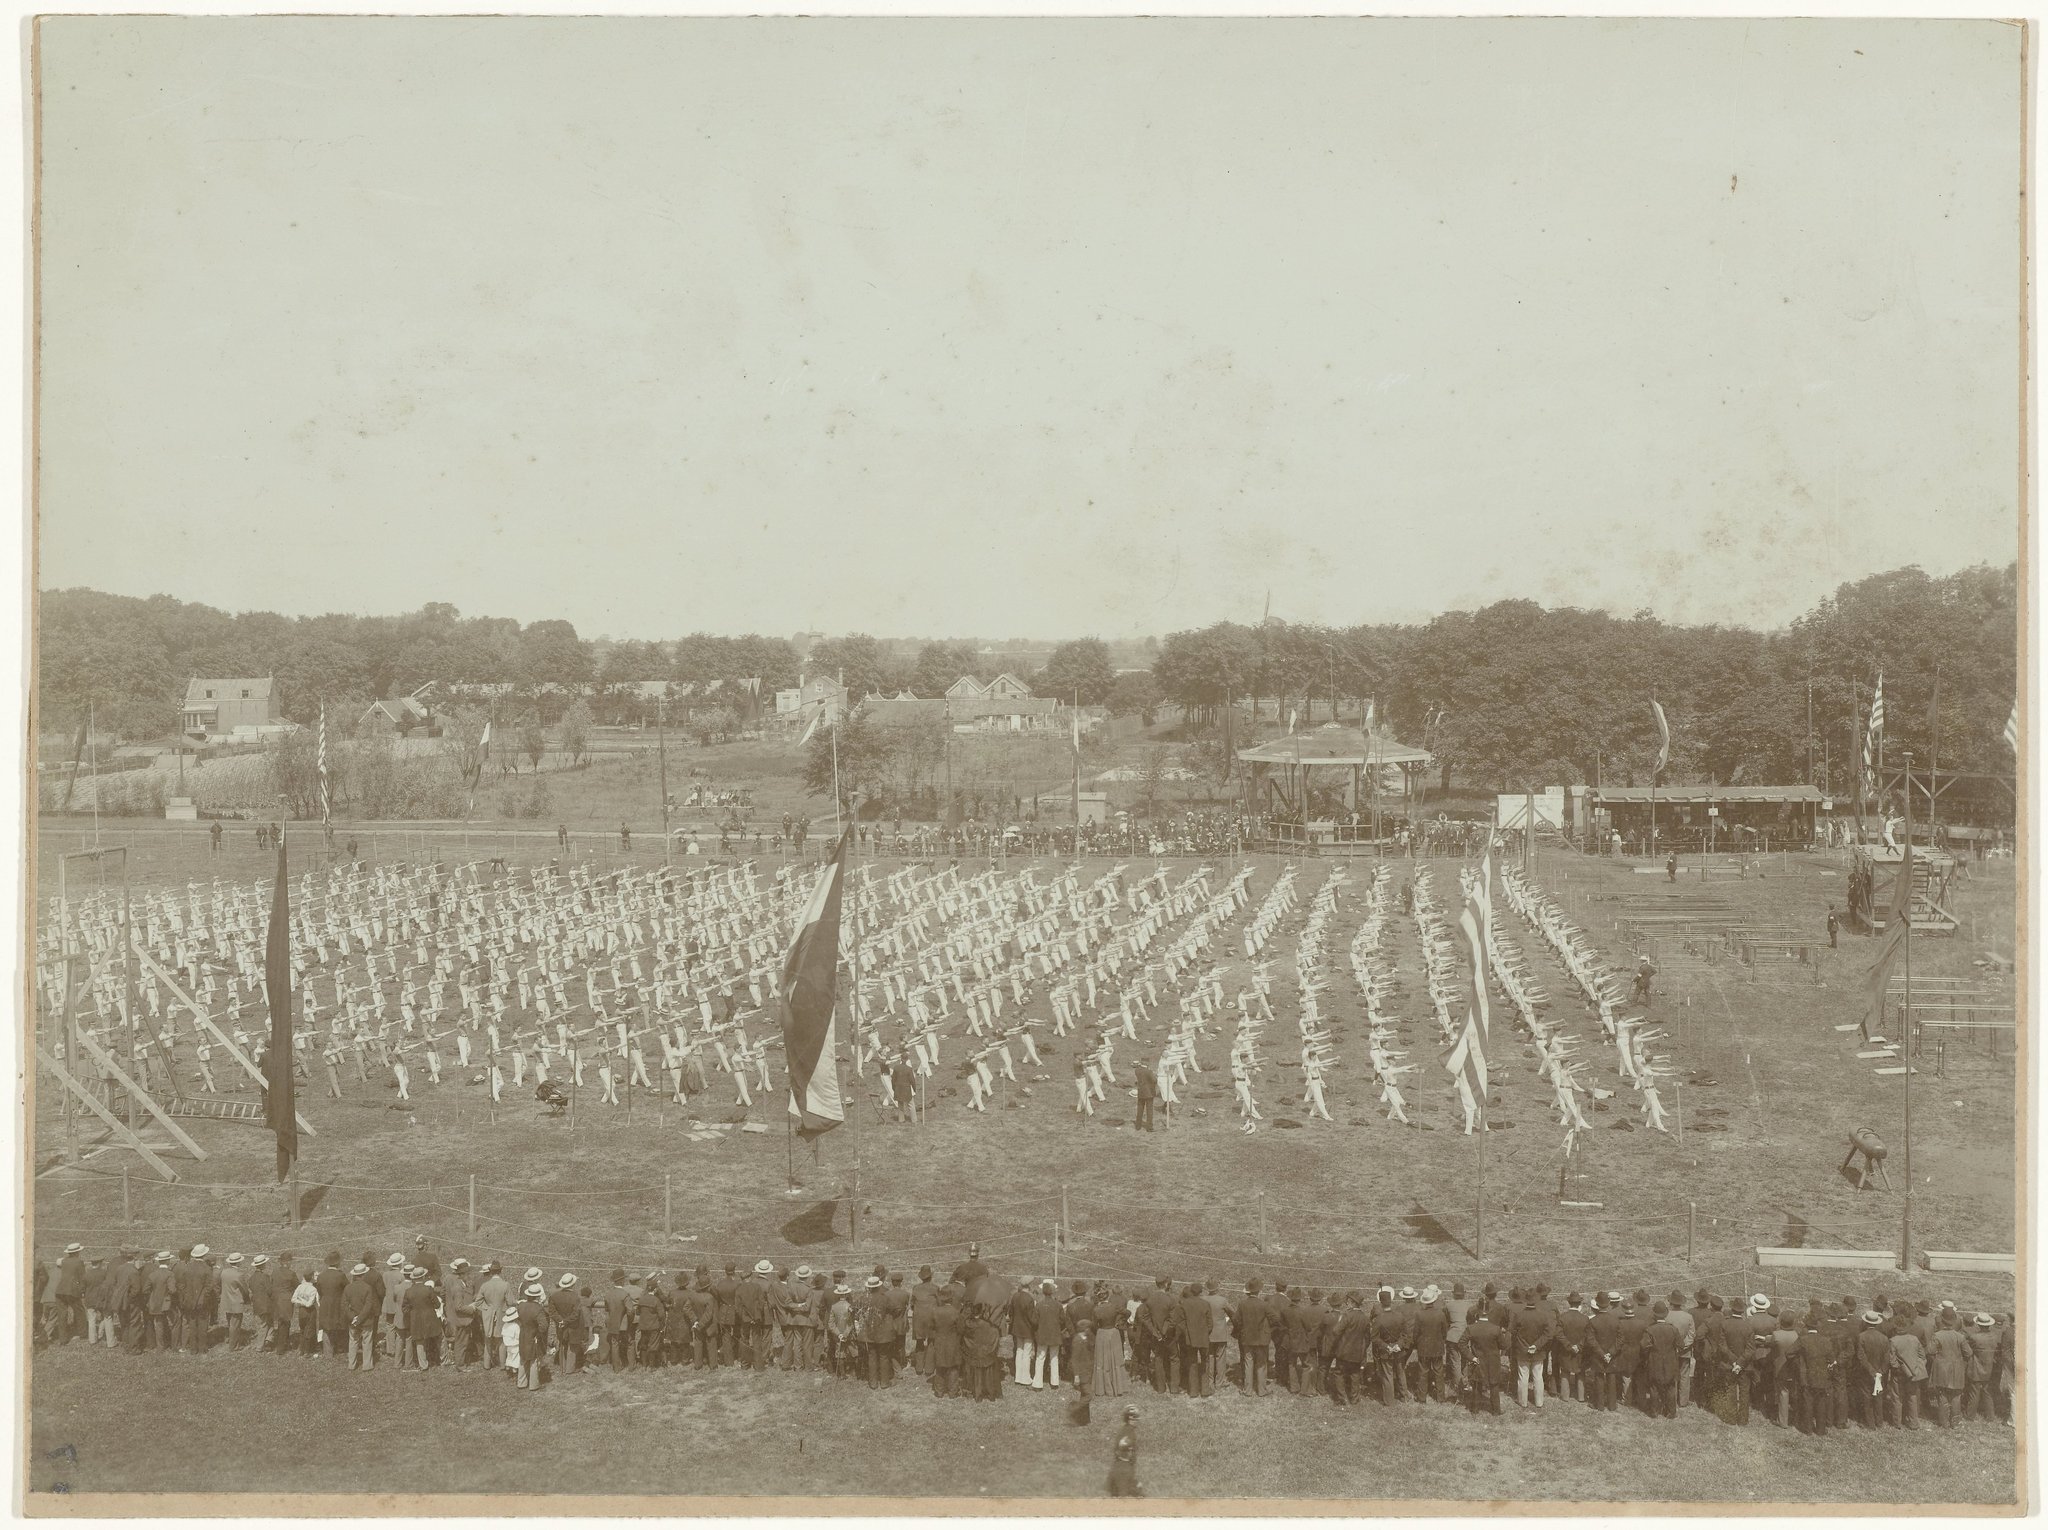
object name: photograph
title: Oefeningen van het Nederlandsch Gymnastiek Verbond op een open veld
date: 1890-1910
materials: paper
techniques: collodion silver print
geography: netherlands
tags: gymnastic exercises on the ground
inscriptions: title: ‘Nederlandsch Gymnastiek verbond’